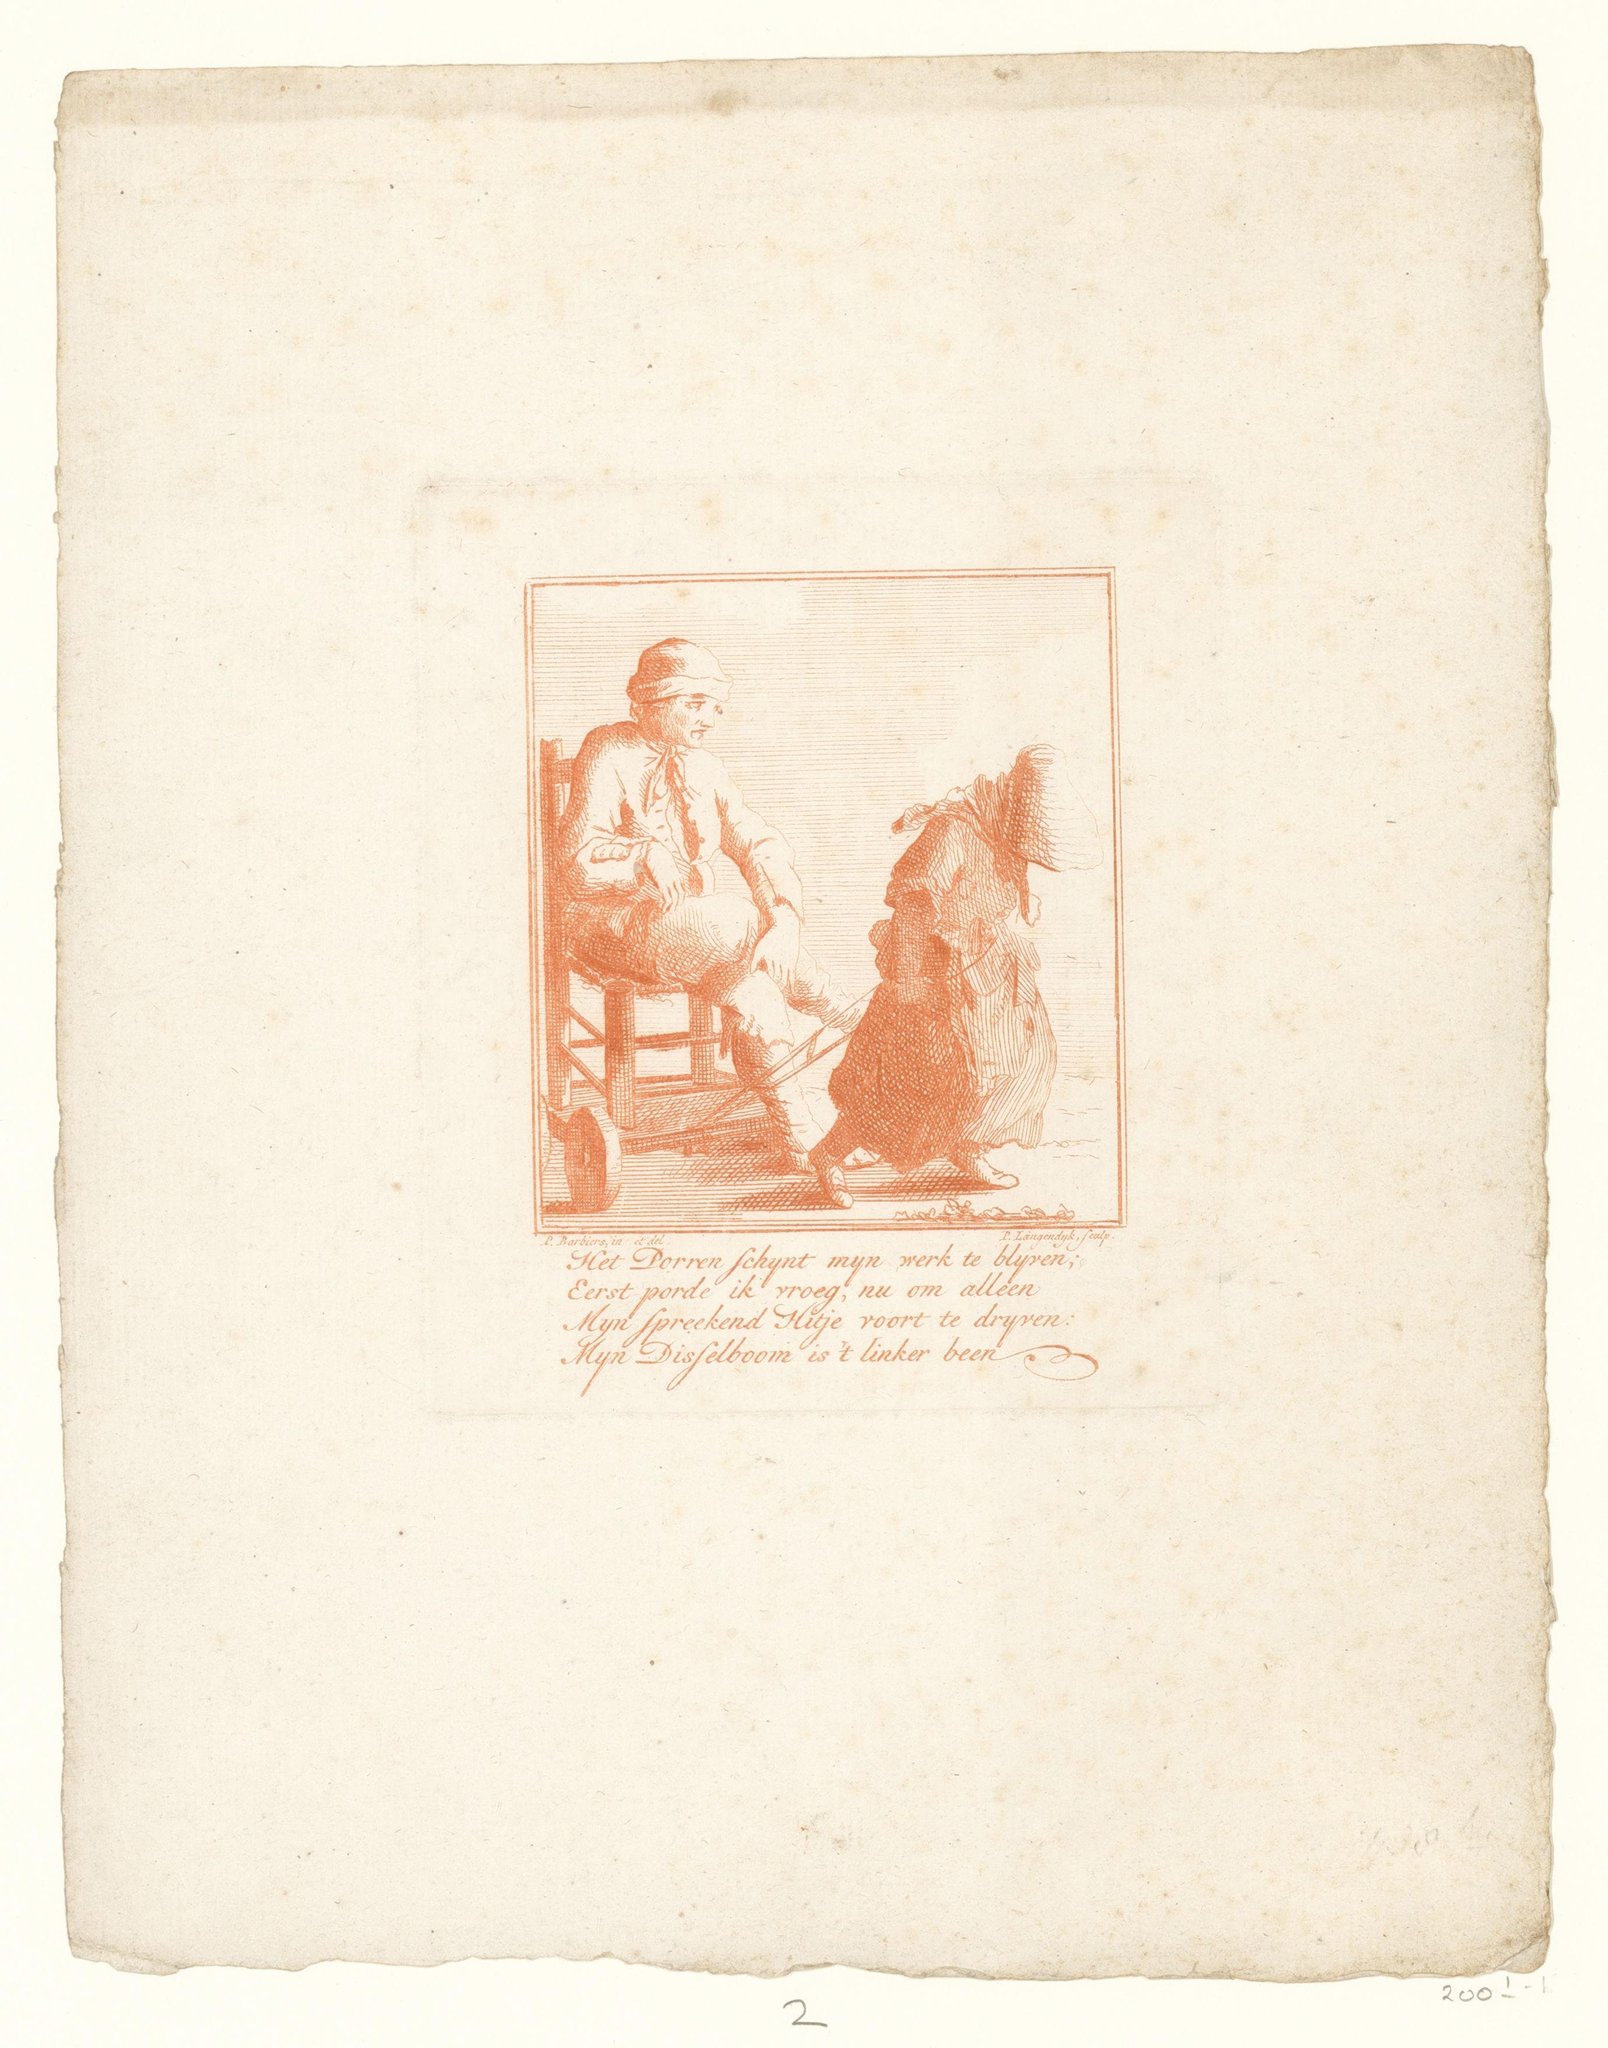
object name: print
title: Amsterdamse straatfiguren rond 1770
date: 1770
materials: paper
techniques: engraving, etching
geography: netherlands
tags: wheelchair, bathchair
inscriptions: collector's mark, collector's mark: Lugt 1641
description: Een kreupele man zit op een stoel met wieltjes en wordt door een vrouwfiguur aan twee stukken touw voortgetrokken. In de marge een vierregelig vers in het Nederlands. Onderdeel van een serie van prenten van Amsterdamse straatfiguren rond 1770. Onderwerpsrubrieken binnen de Atlas Zeden en Gewoonten: Mannelijk beroep en bedrijf: Marskramers, straatventers, straatslijpers, bedelaars, straatvertooningen enz.